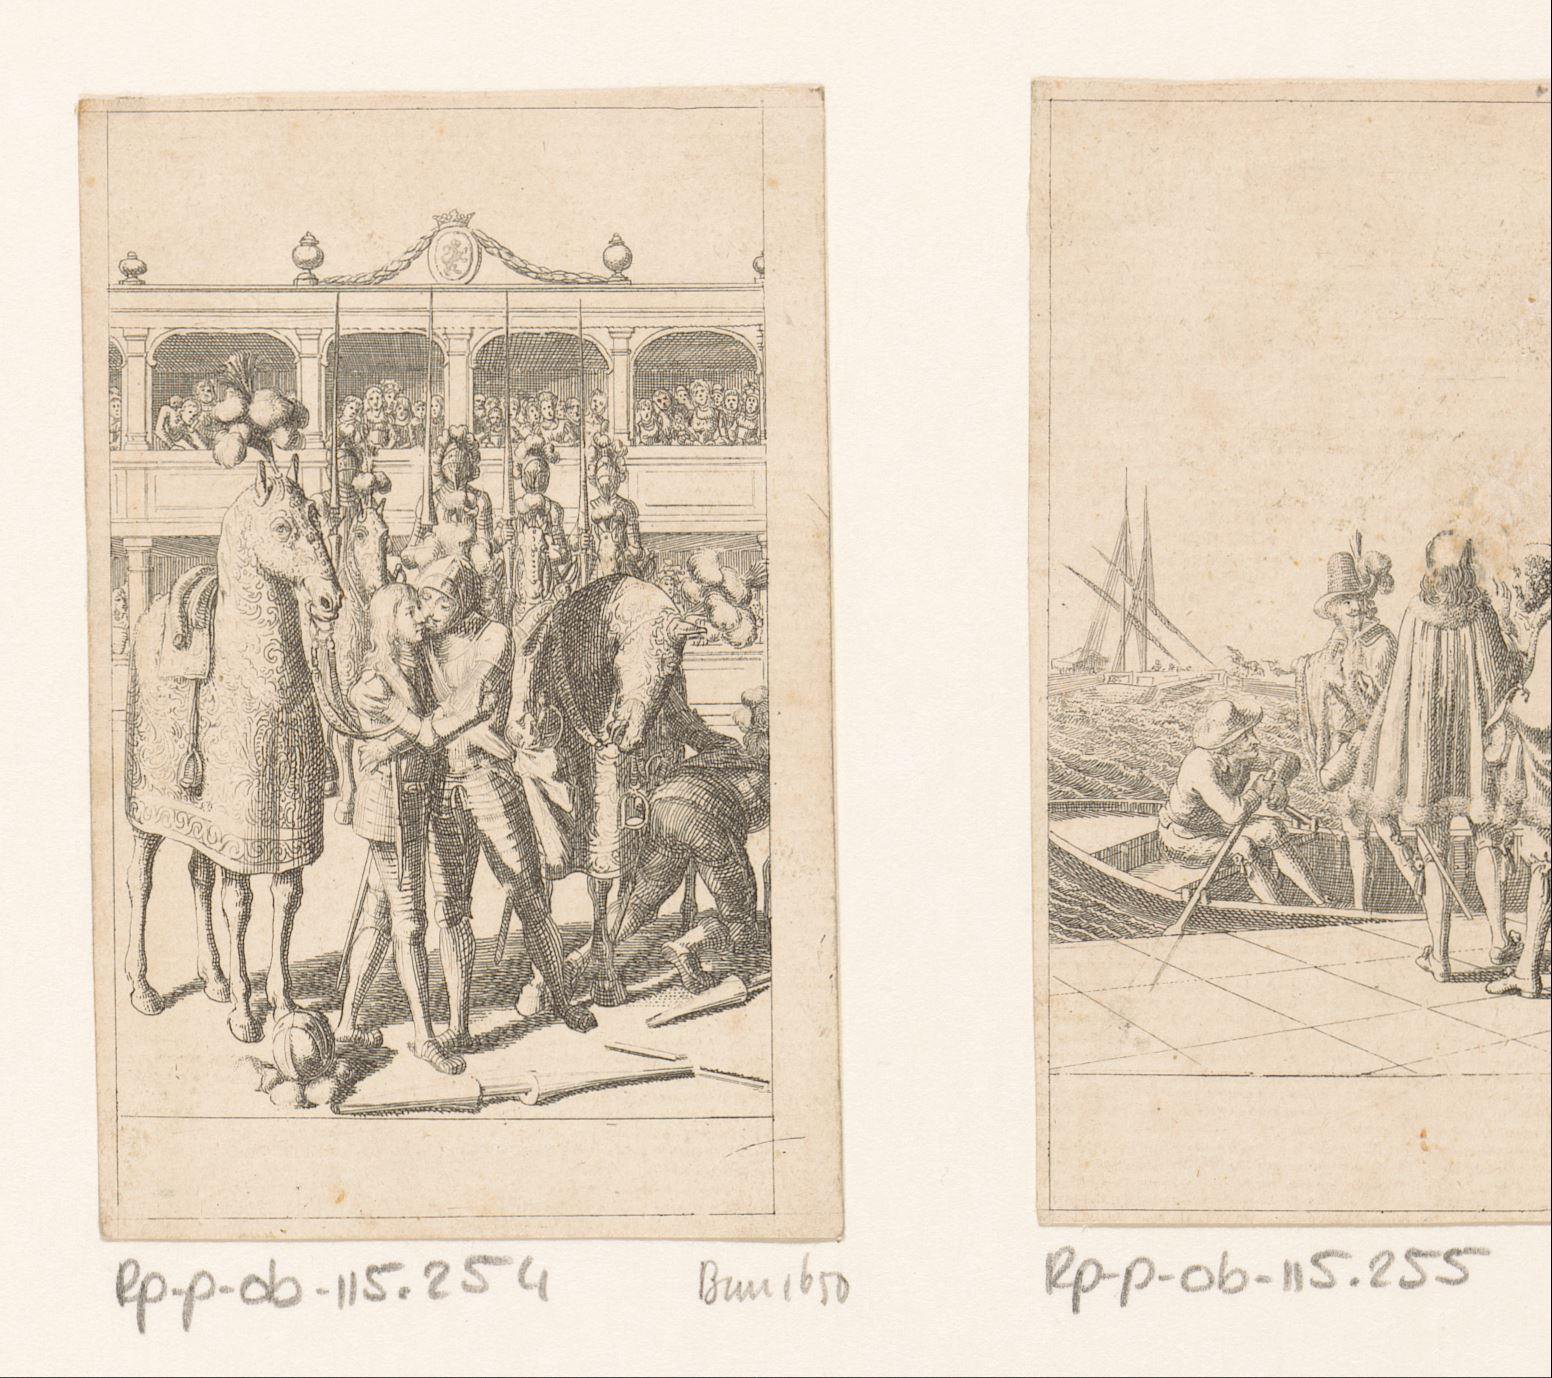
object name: print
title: Bertrand du Guesclin omhelsd door zijn vader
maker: daniel nikolaus chodowiecki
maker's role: draughtsman, print maker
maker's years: 1726-1801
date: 1793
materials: paper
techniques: etching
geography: berlin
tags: history, embracing each other, kissing, joust, tilt, knight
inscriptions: collector's mark: Lugt 2228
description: Vervaardigd als één van twaalf voorstellingen uit de oudste, middelste en nieuwste geschiedenis. Latere staat gebruikt voor: Genealogischen Calender zur angenehmen und nützlichen Unterhaltung auf das Jahr 1794. Berlijn: Königl. Akademie der Wissenschaften, [1793].